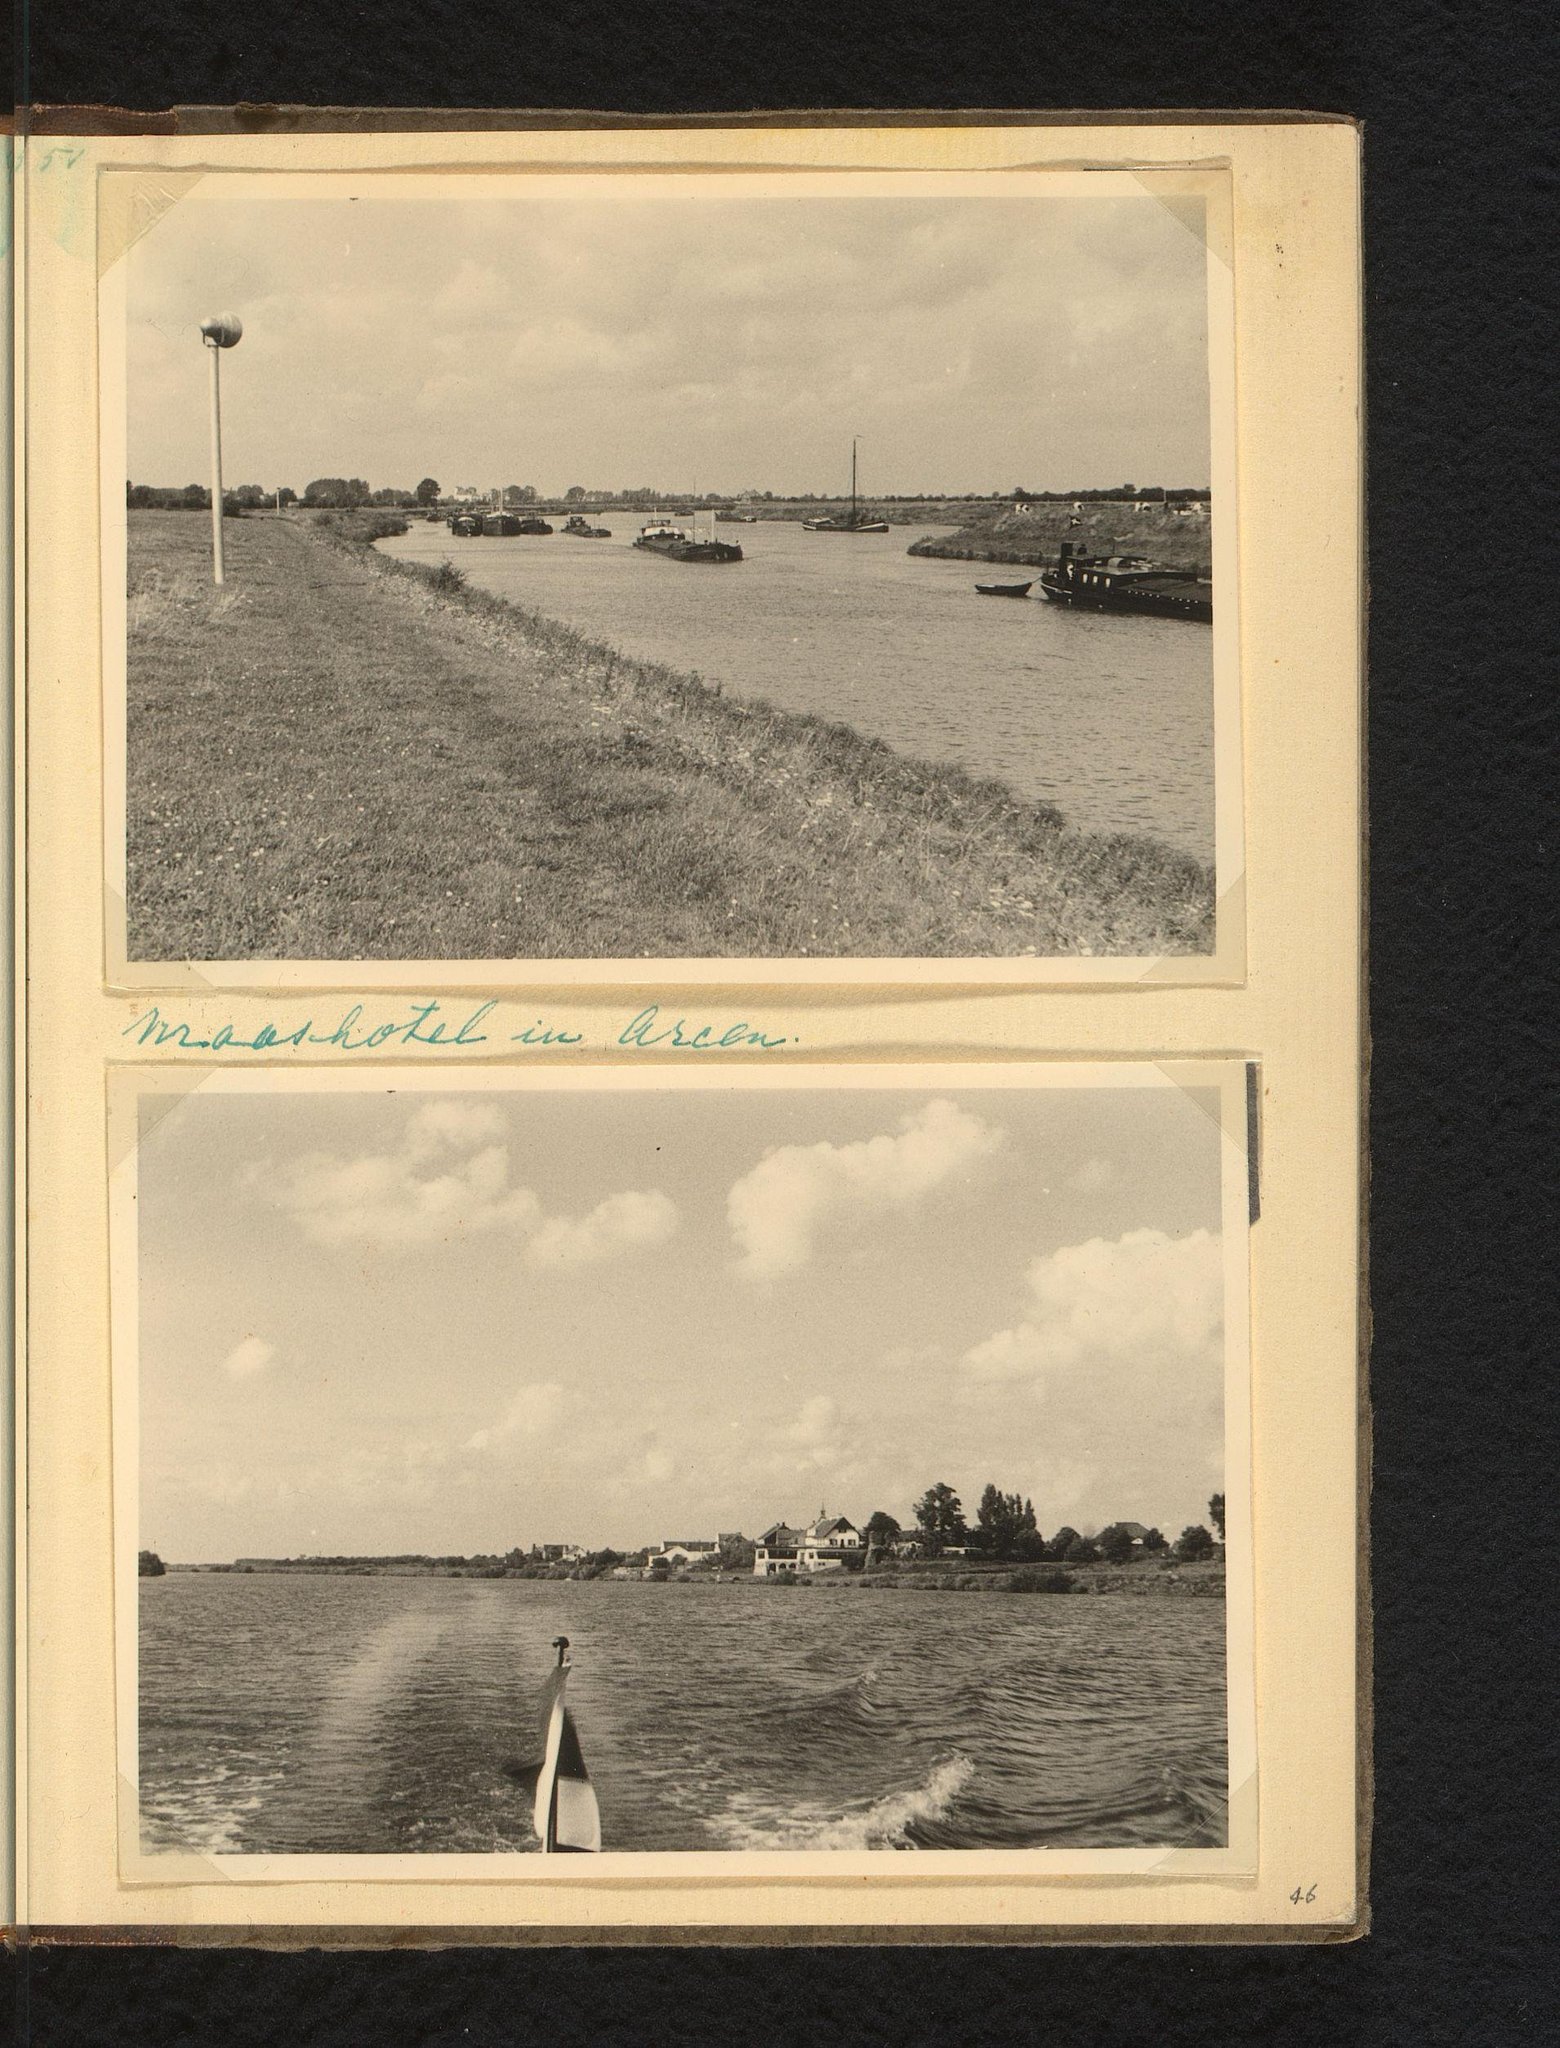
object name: photograph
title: Twee foto's van een boottocht op de Maas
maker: Anonymous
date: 1951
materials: paper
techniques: gelatin silver print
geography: meuse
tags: river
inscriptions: inscription: ‘Maashotel in Arcen’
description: Deze foto's maken deel uit van een album.